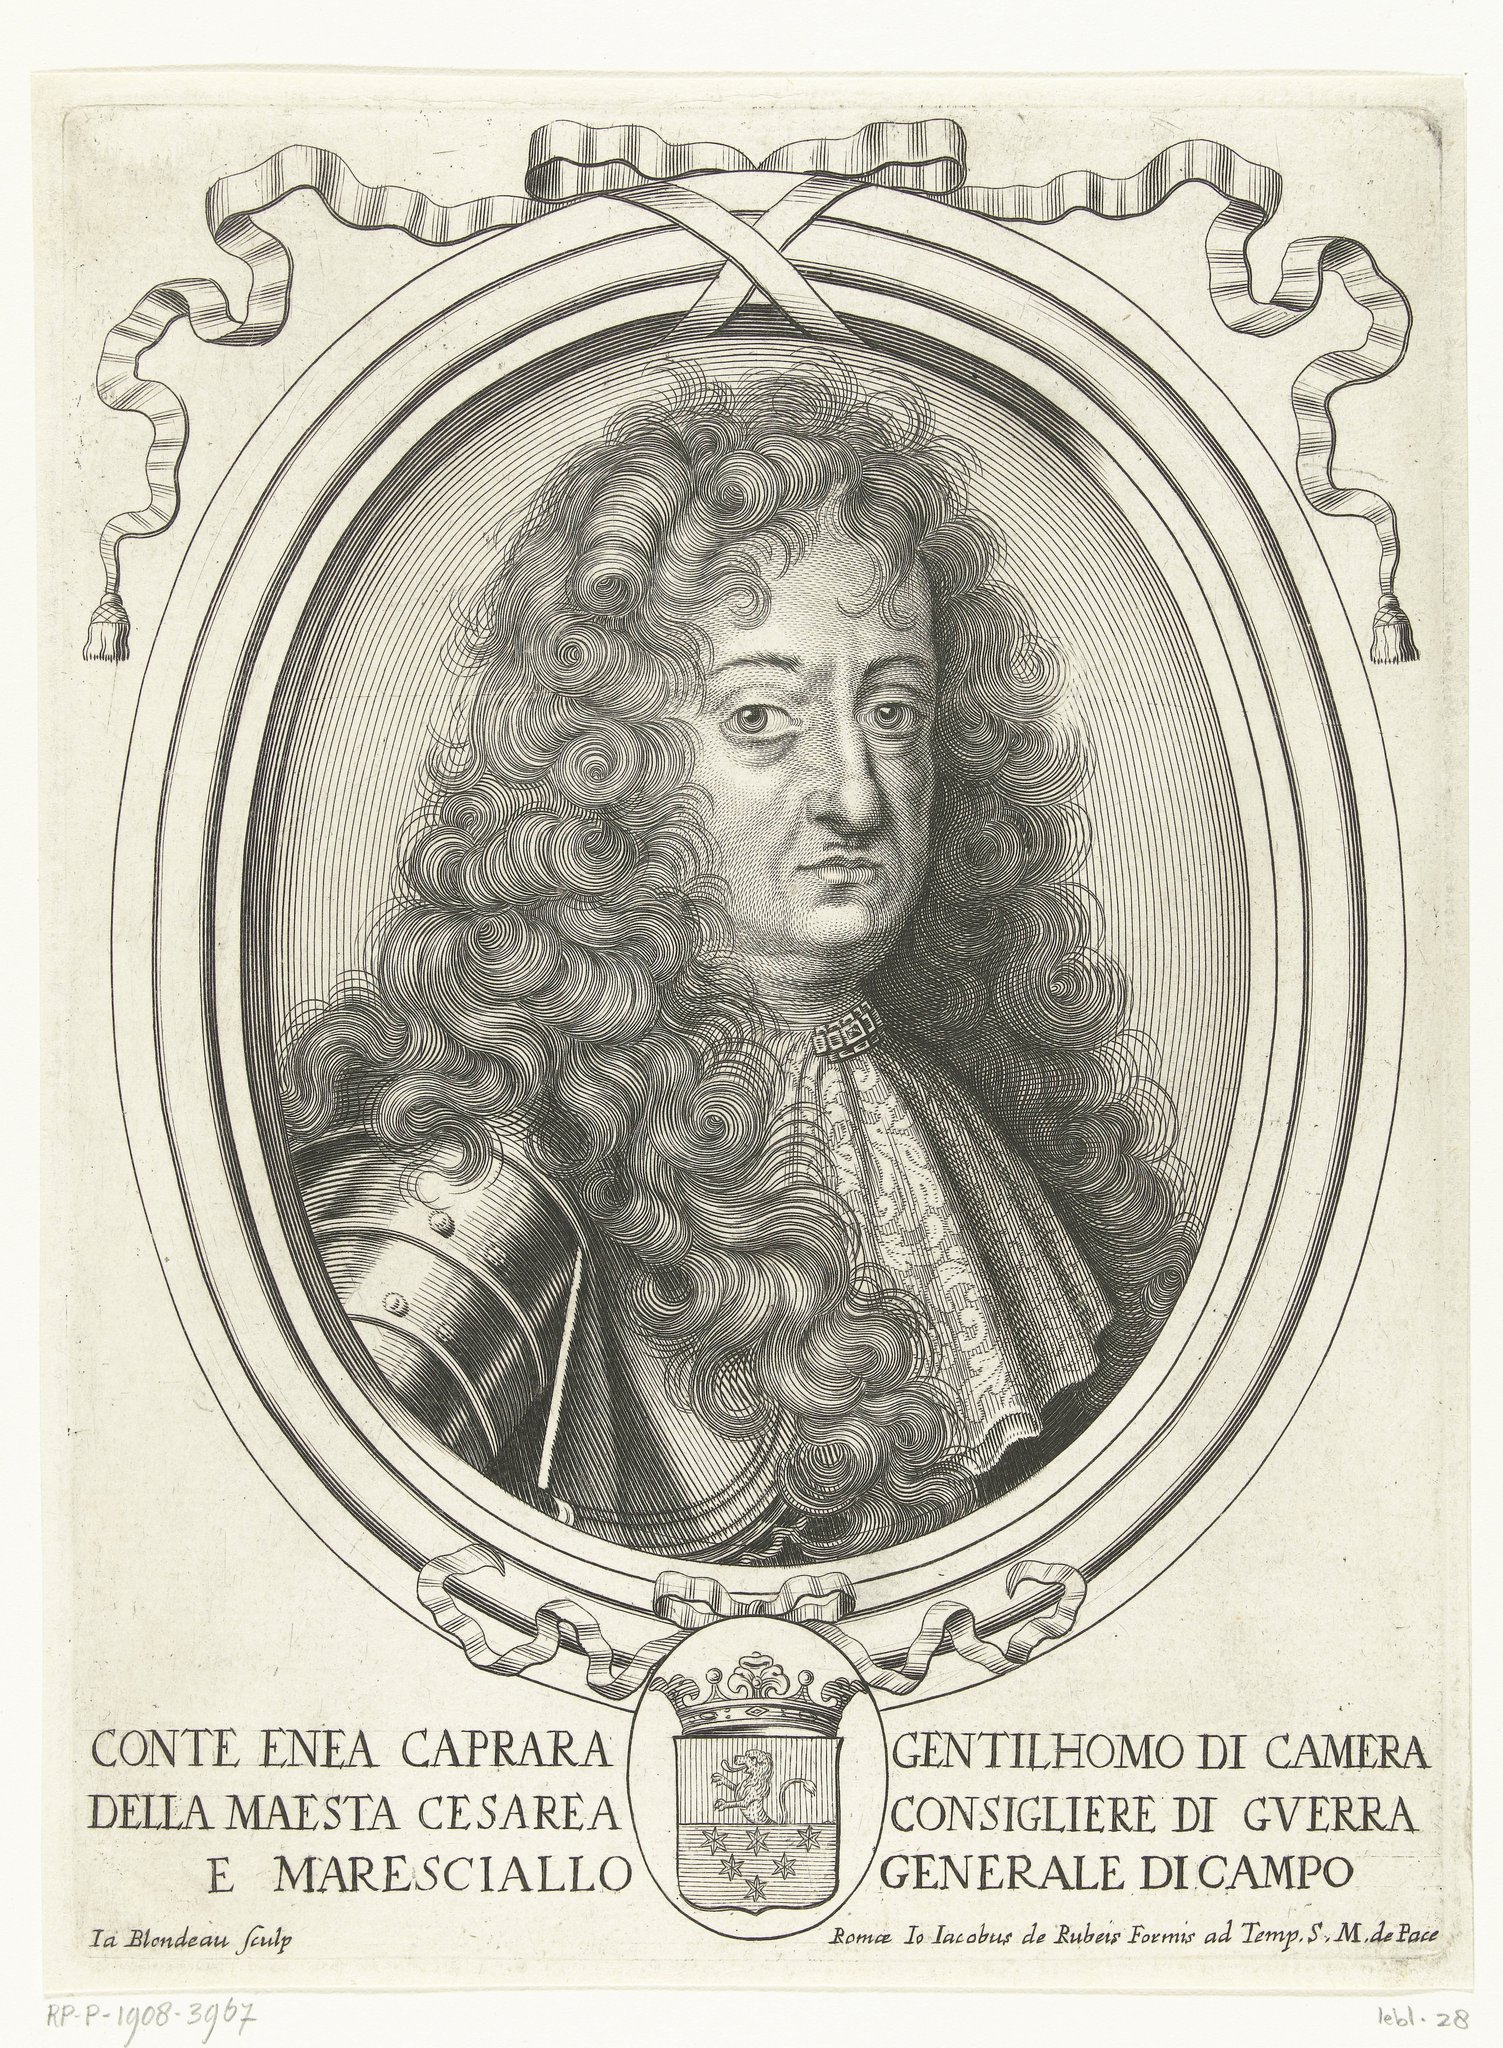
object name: print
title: Portret van graaf Enea Silvio Caprara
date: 1665-1698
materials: paper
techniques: engraving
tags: bologna, diplomaat, veldmaarschalk, enea silvio caprara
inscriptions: collector's mark: Lugt 2228